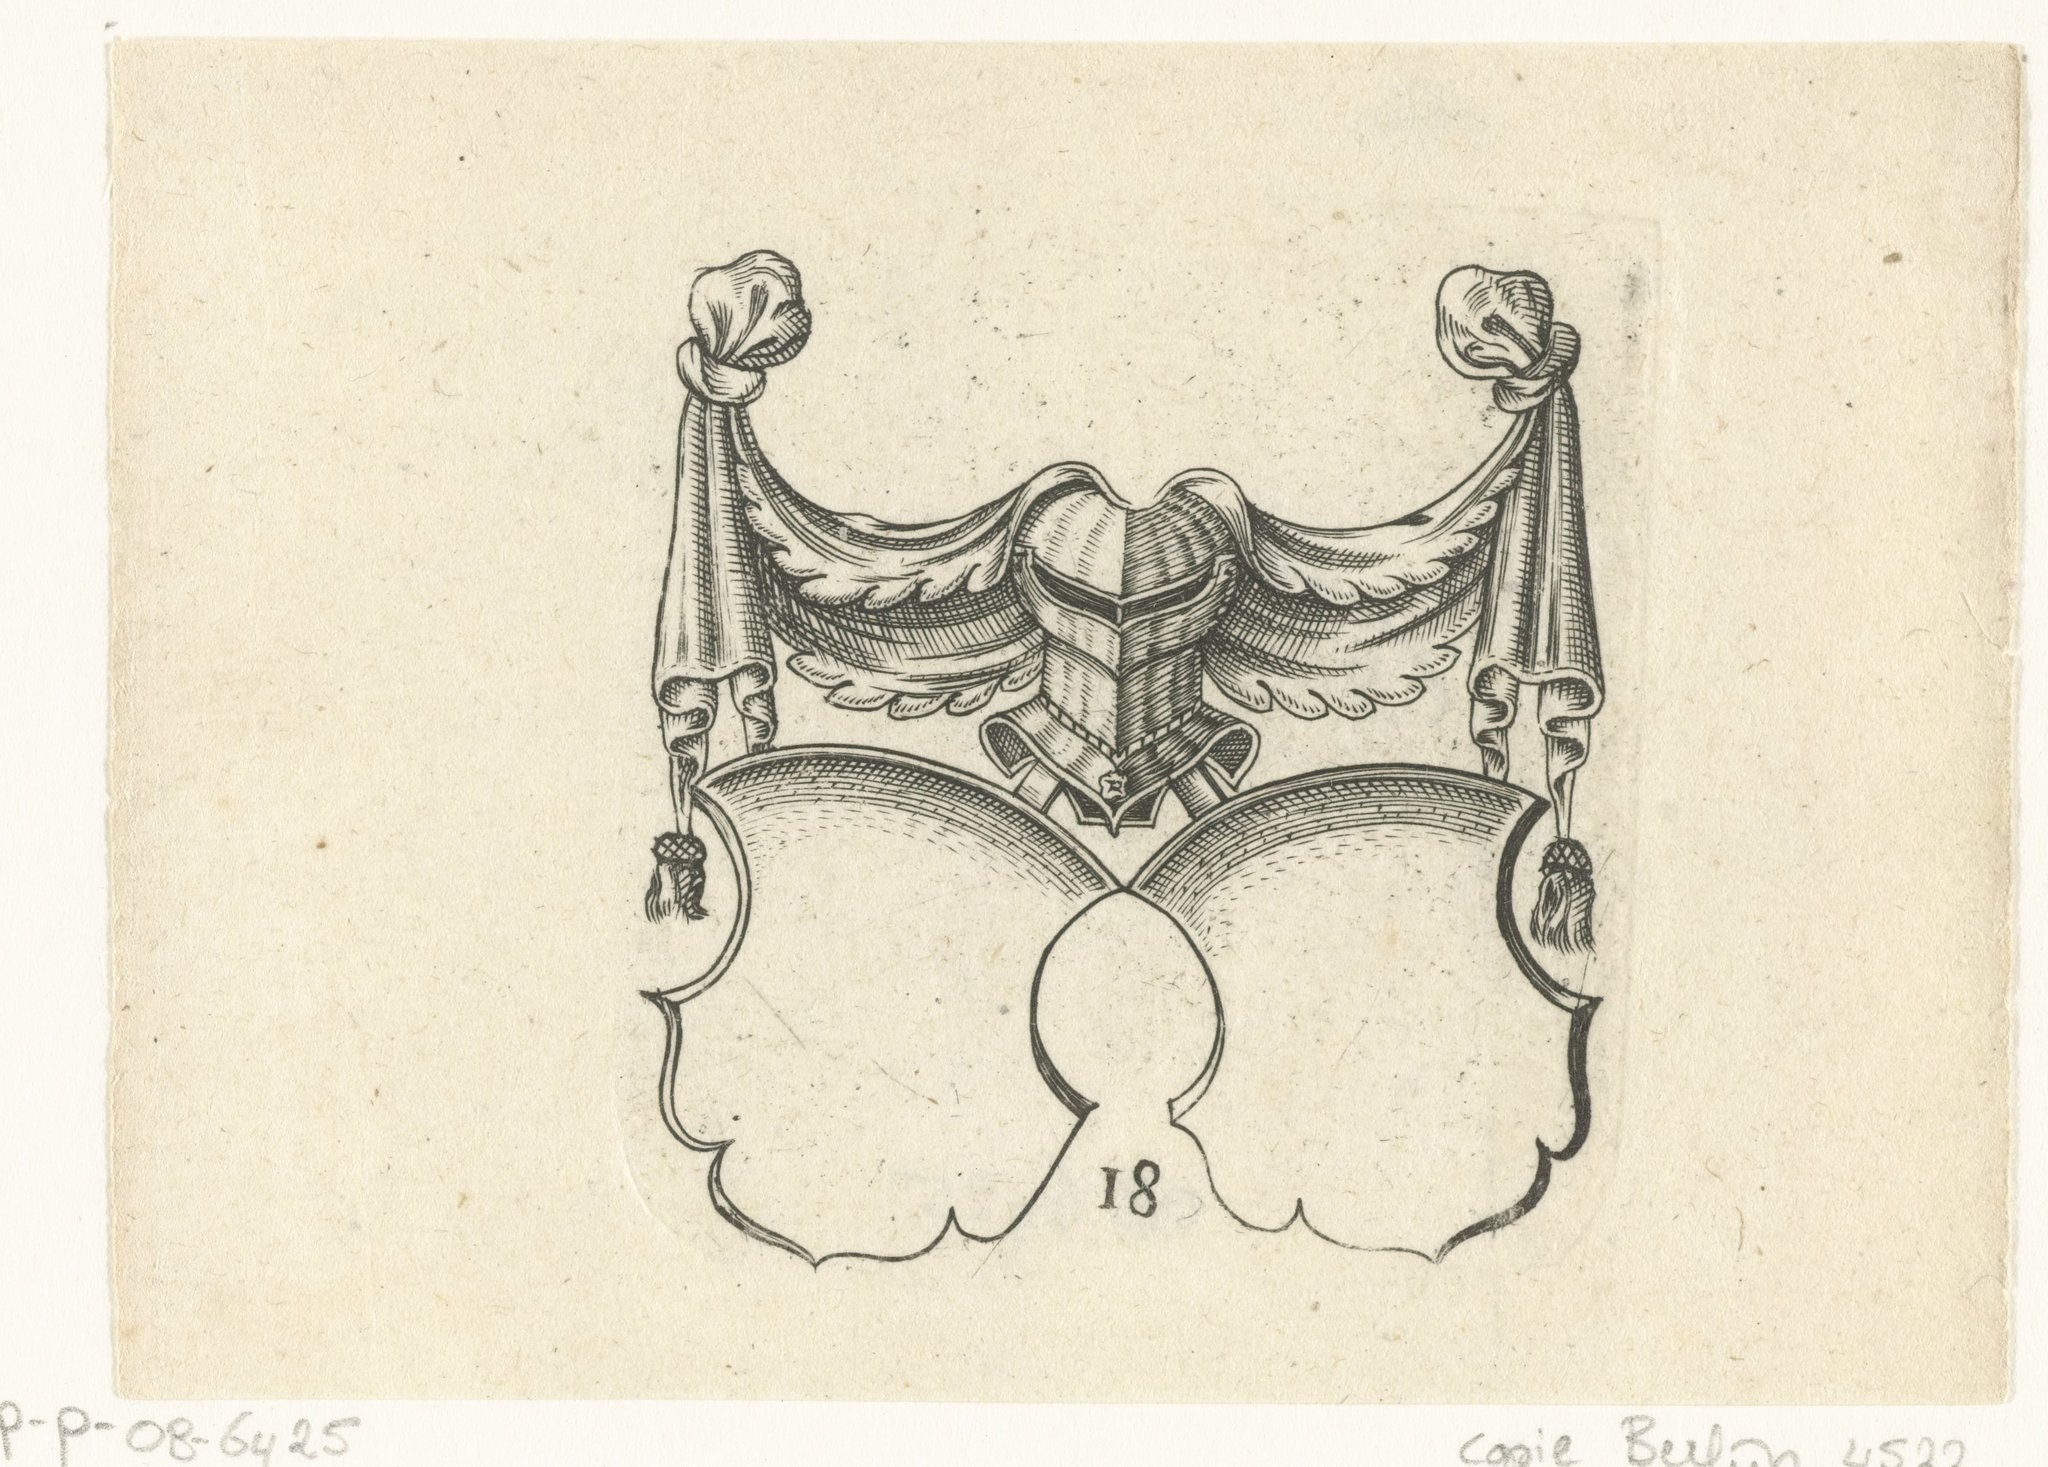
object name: ornament print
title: Verscheyden Wapenen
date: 1625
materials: paper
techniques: engraving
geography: amsterdam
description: Erboven staat een helm met aan beide kanten een draperie. Tegenzijdige kopie naar wapenschilden van Theodor de Bry in het boek Emblemata Nobilitati.... Blad uit serie wapenschilden met lege compartimenten.